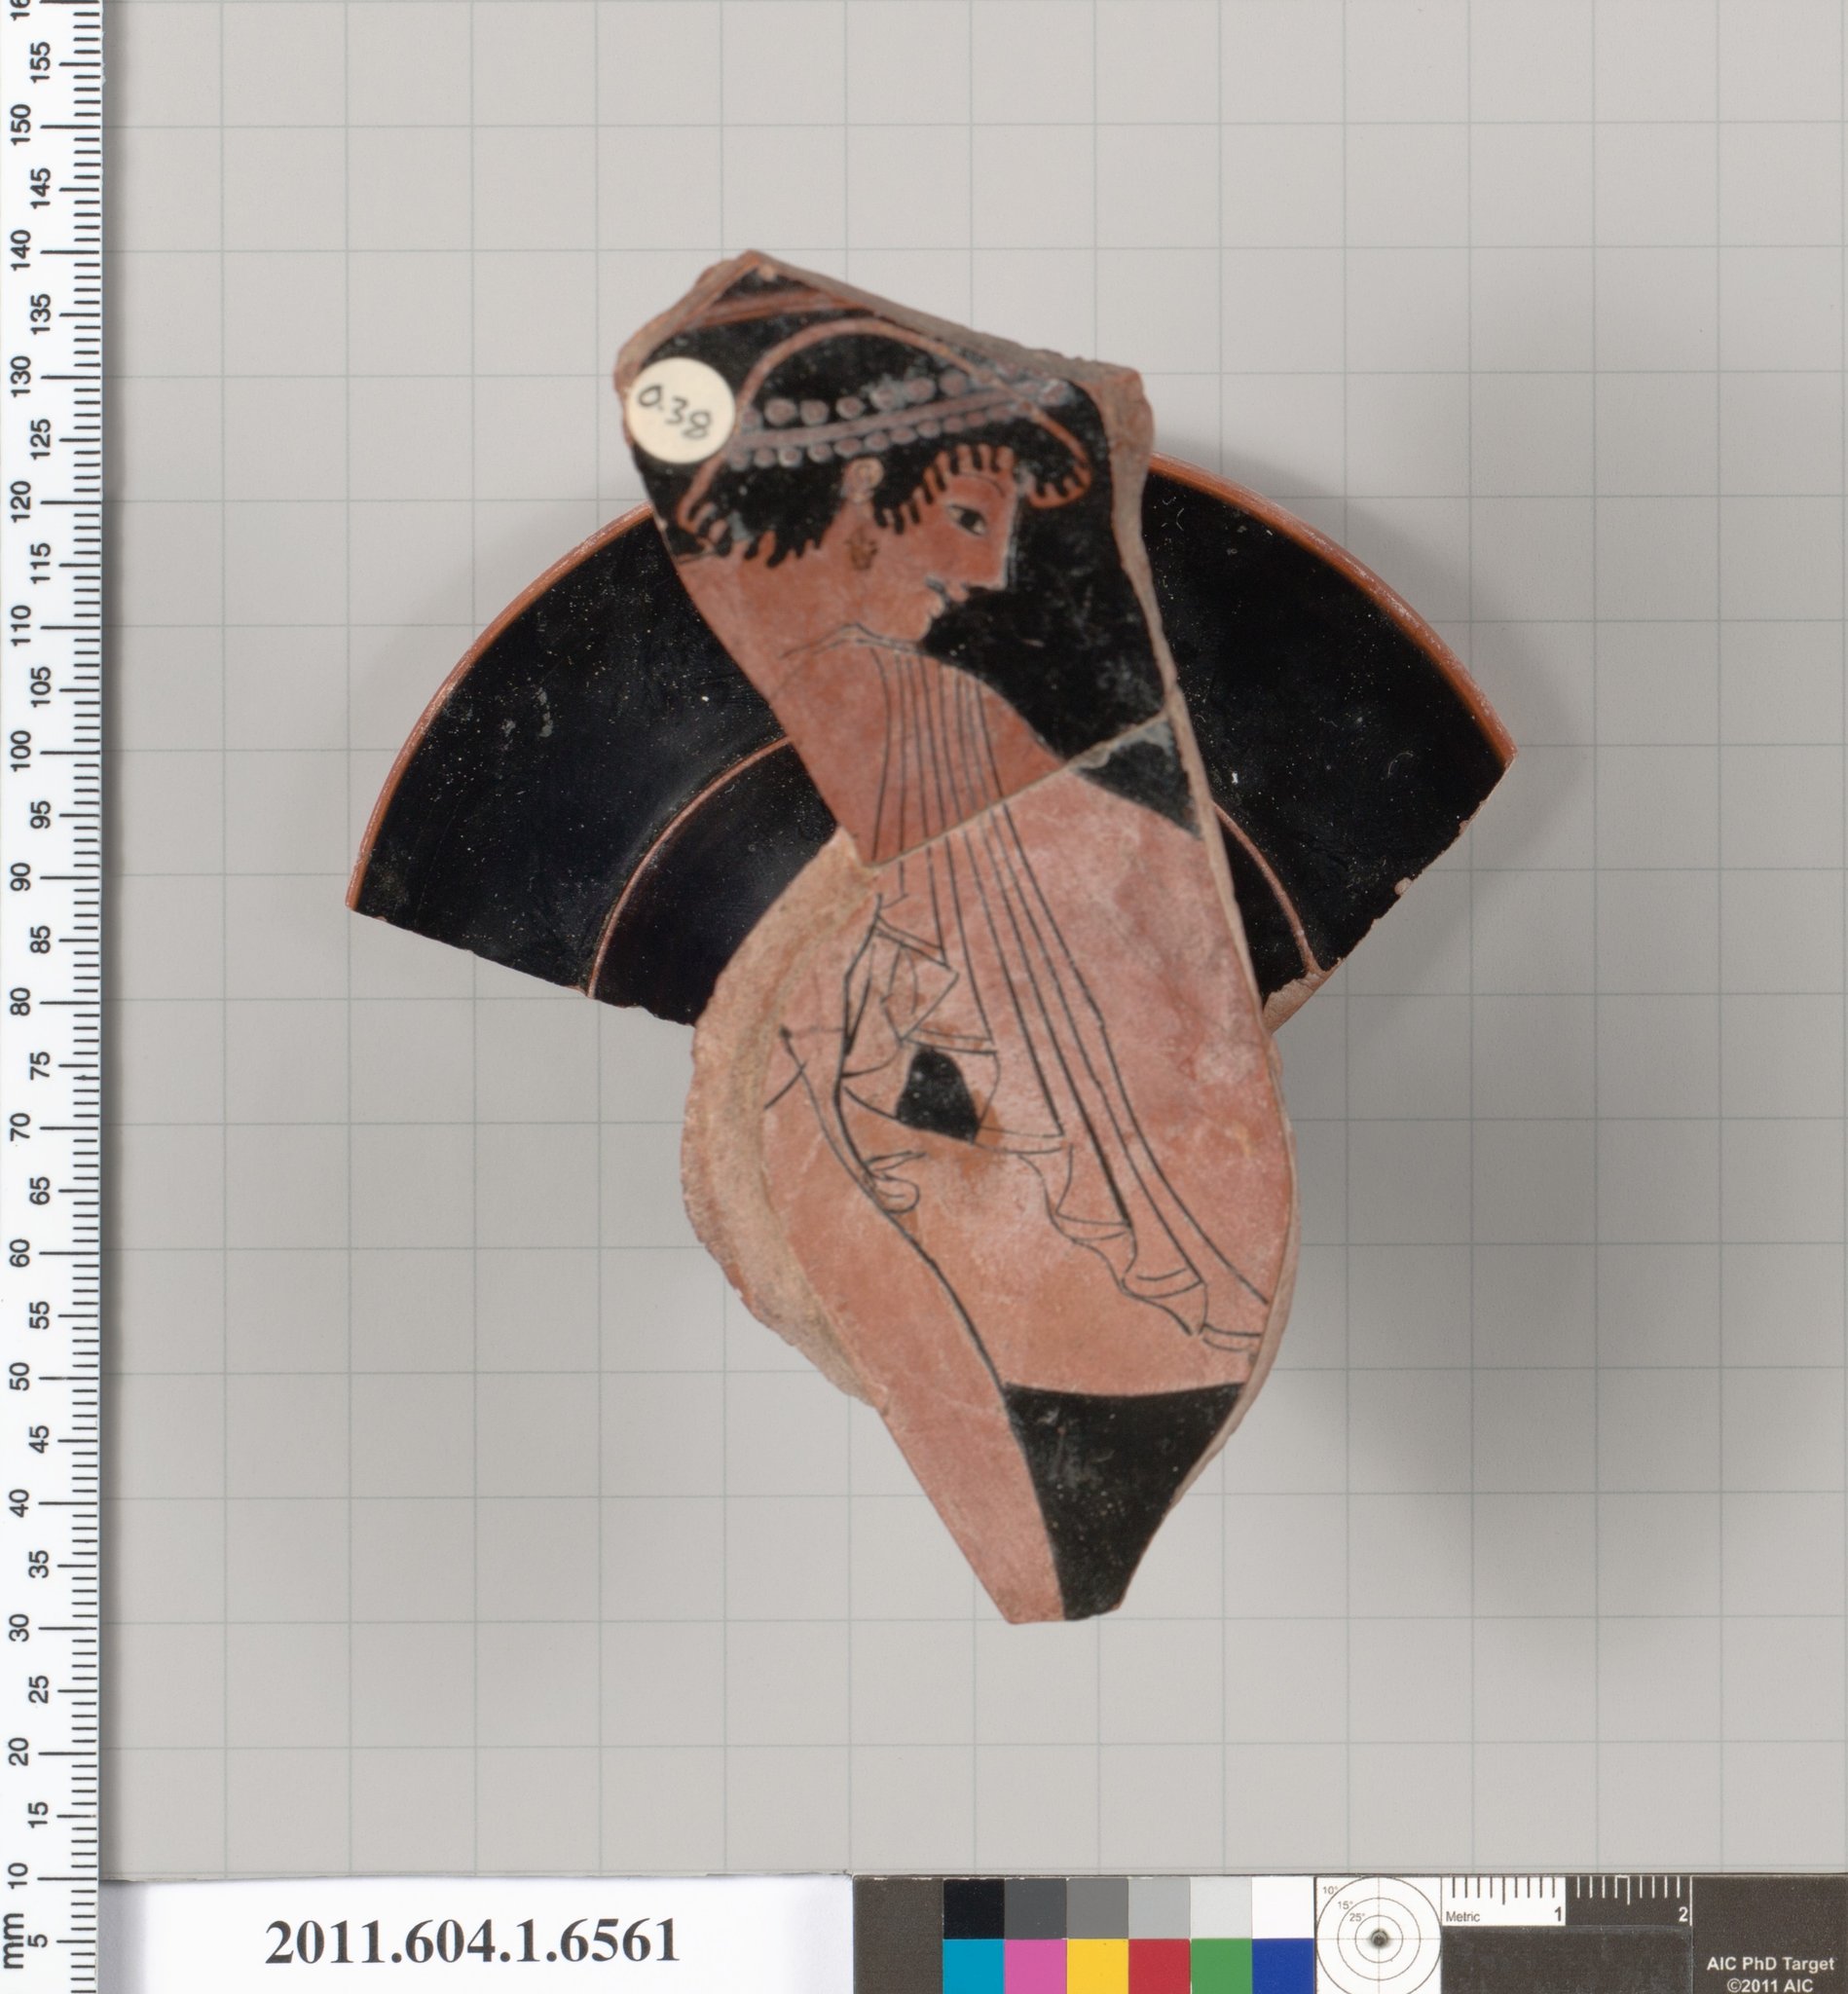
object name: kylix fragment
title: Terracotta fragment of a kylix (drinking cup)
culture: greek, attic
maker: colmar painter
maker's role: artist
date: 490-480 BCE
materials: terracotta